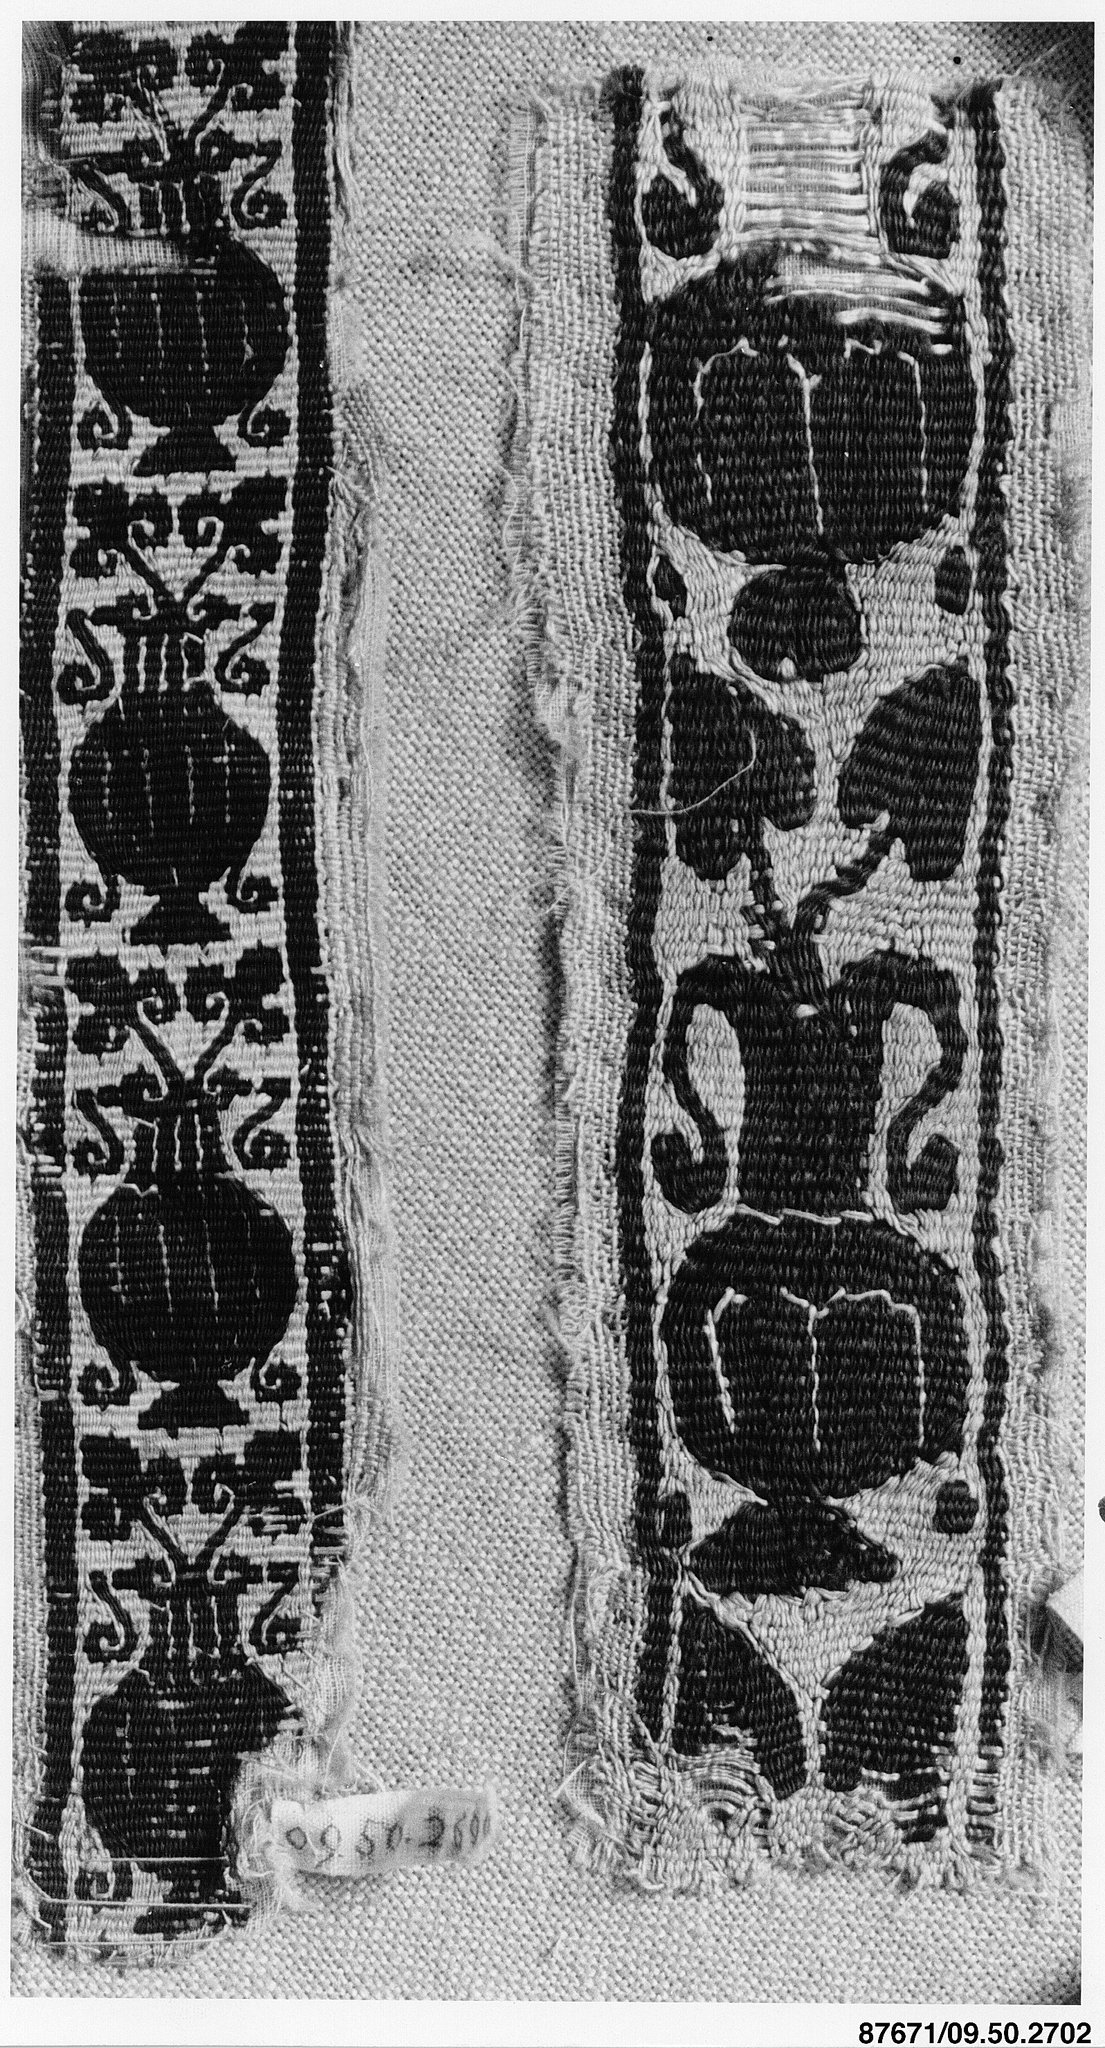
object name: band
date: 301-500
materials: linen, wool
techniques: weave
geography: egypt